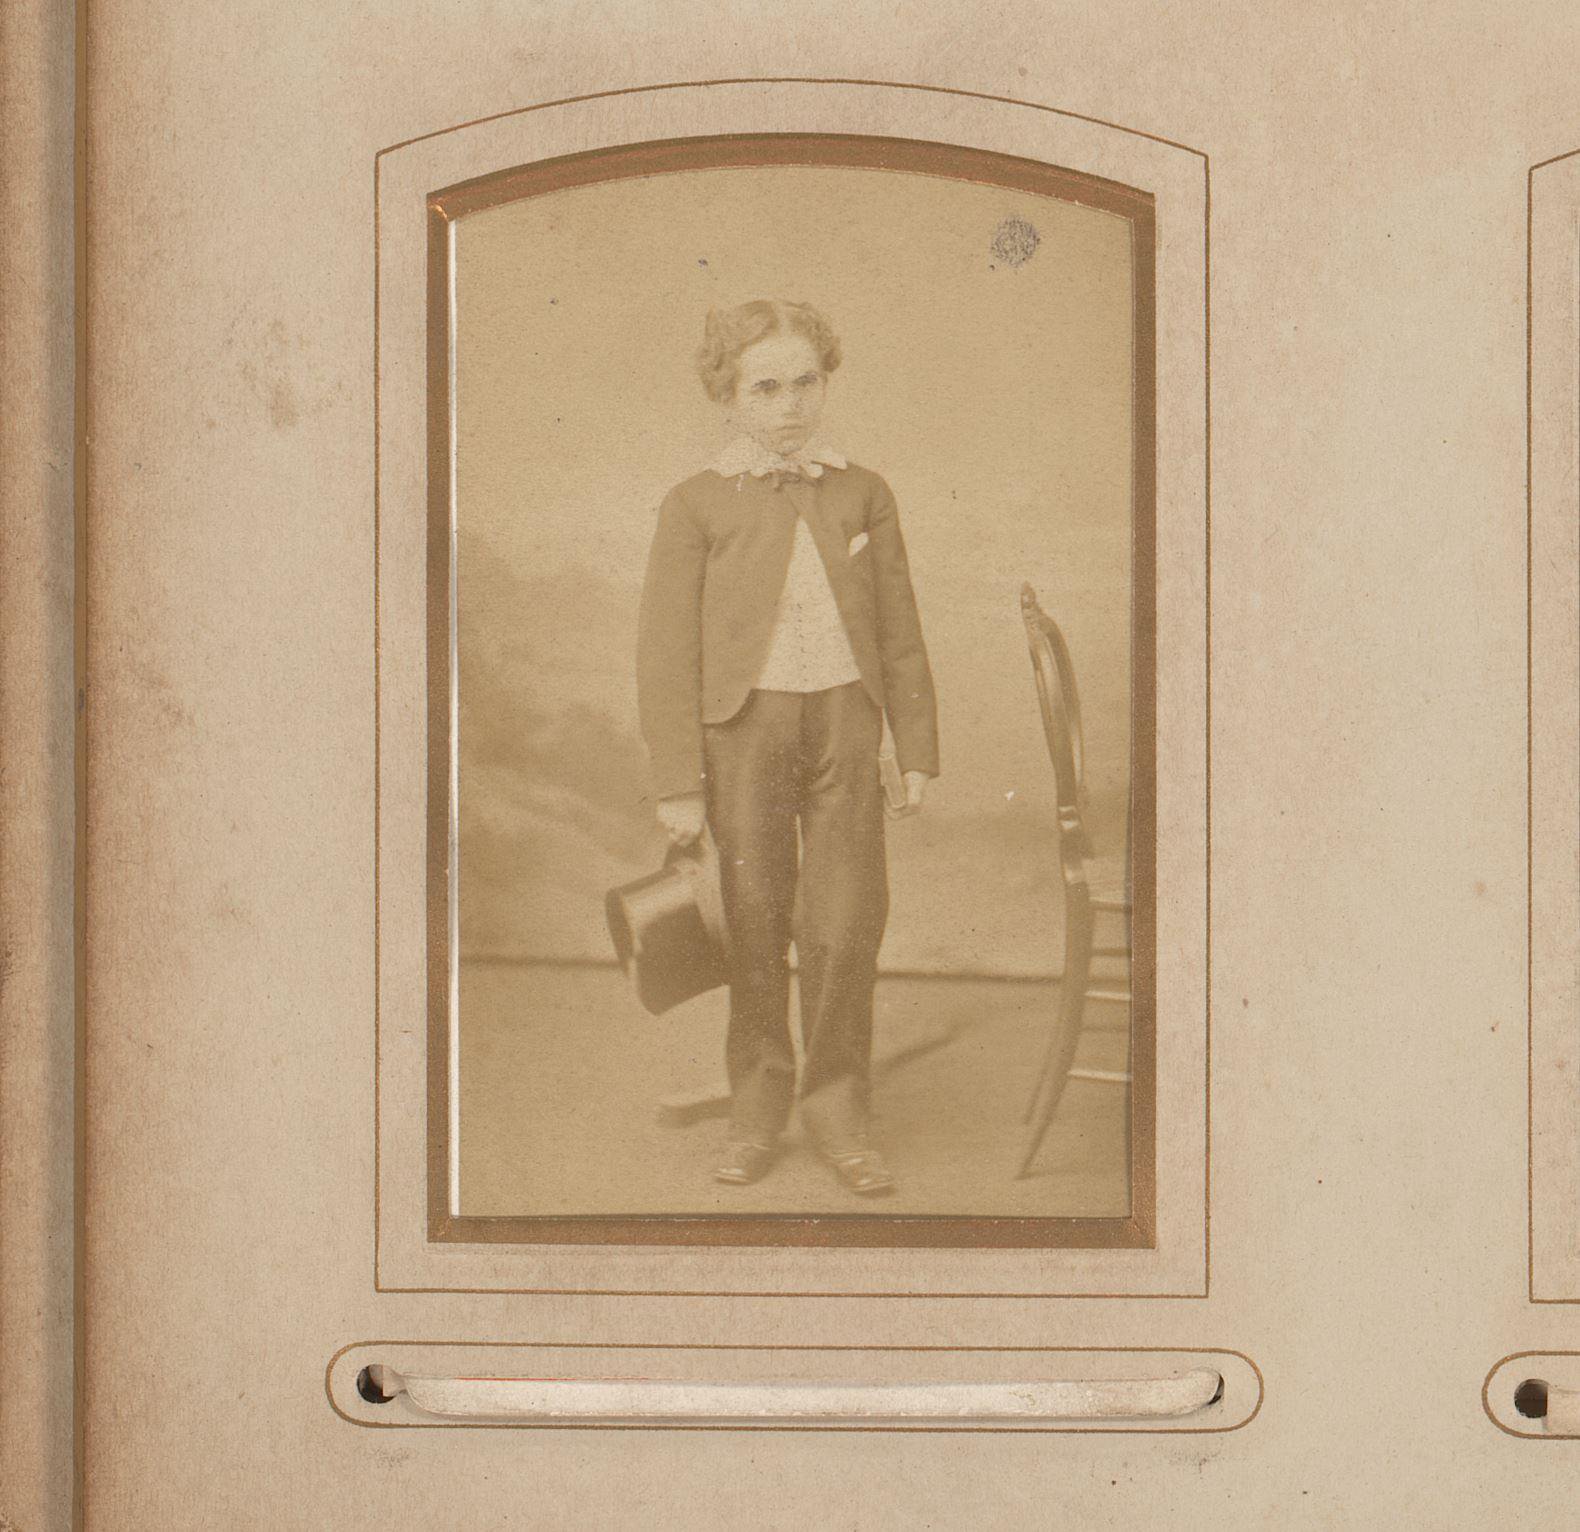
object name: album leaf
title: Portret van een staande jongen met hoge hoed in de hand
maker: ladislas straszak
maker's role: fotograaf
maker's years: 1826-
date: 1867-1875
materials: cardboard, celluloid, photographic support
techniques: albumen print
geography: surabaya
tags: boy (child between toddler and youth), historical persons, head-gear: top hat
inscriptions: inscription: ‘No.../ Photographie/ L. Straszak/ 9, Rue Neuve, 9./ BRUXELLES/ SUCCURSALE/ OSTENDE/ Hôtel de Flandre.’